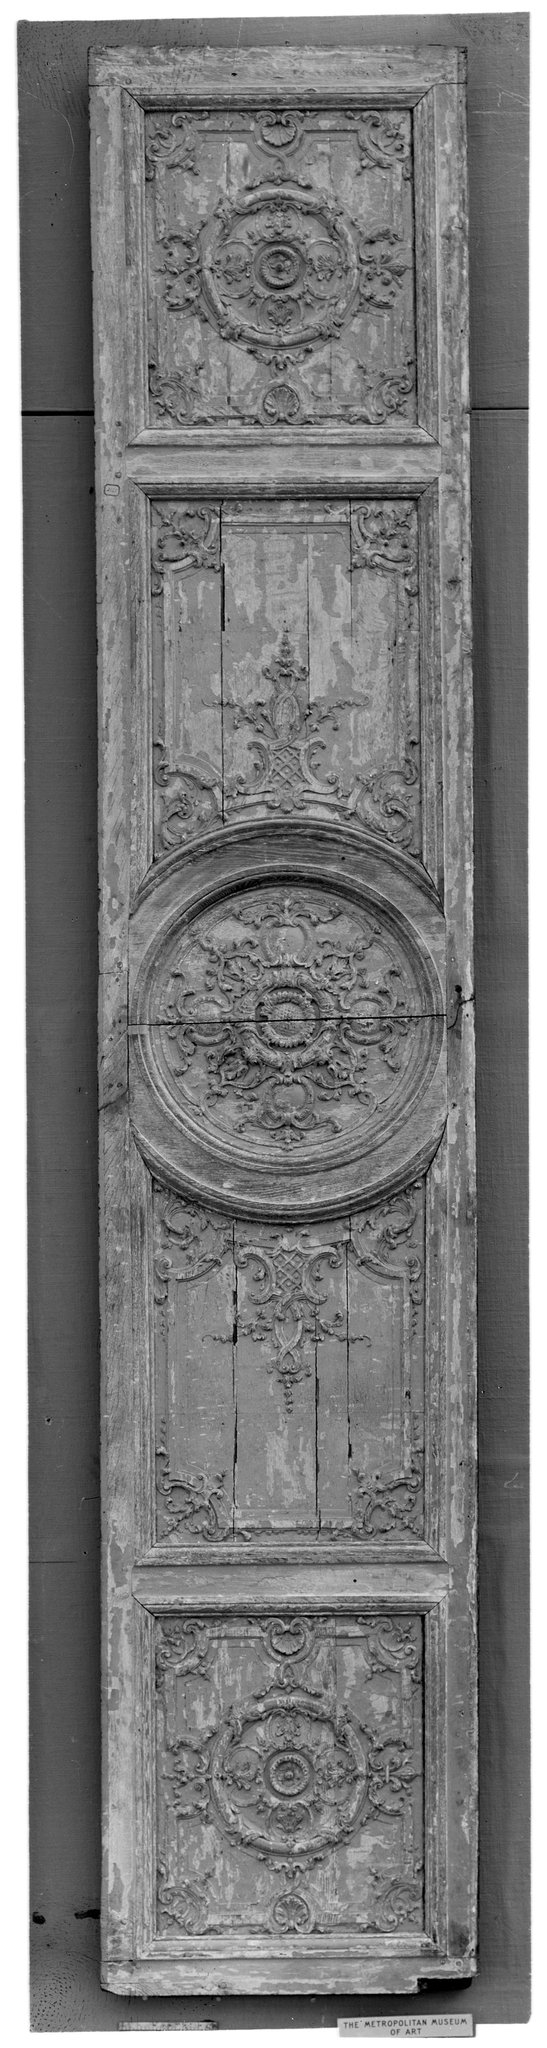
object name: panel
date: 1667-1733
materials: wood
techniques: carving, painting